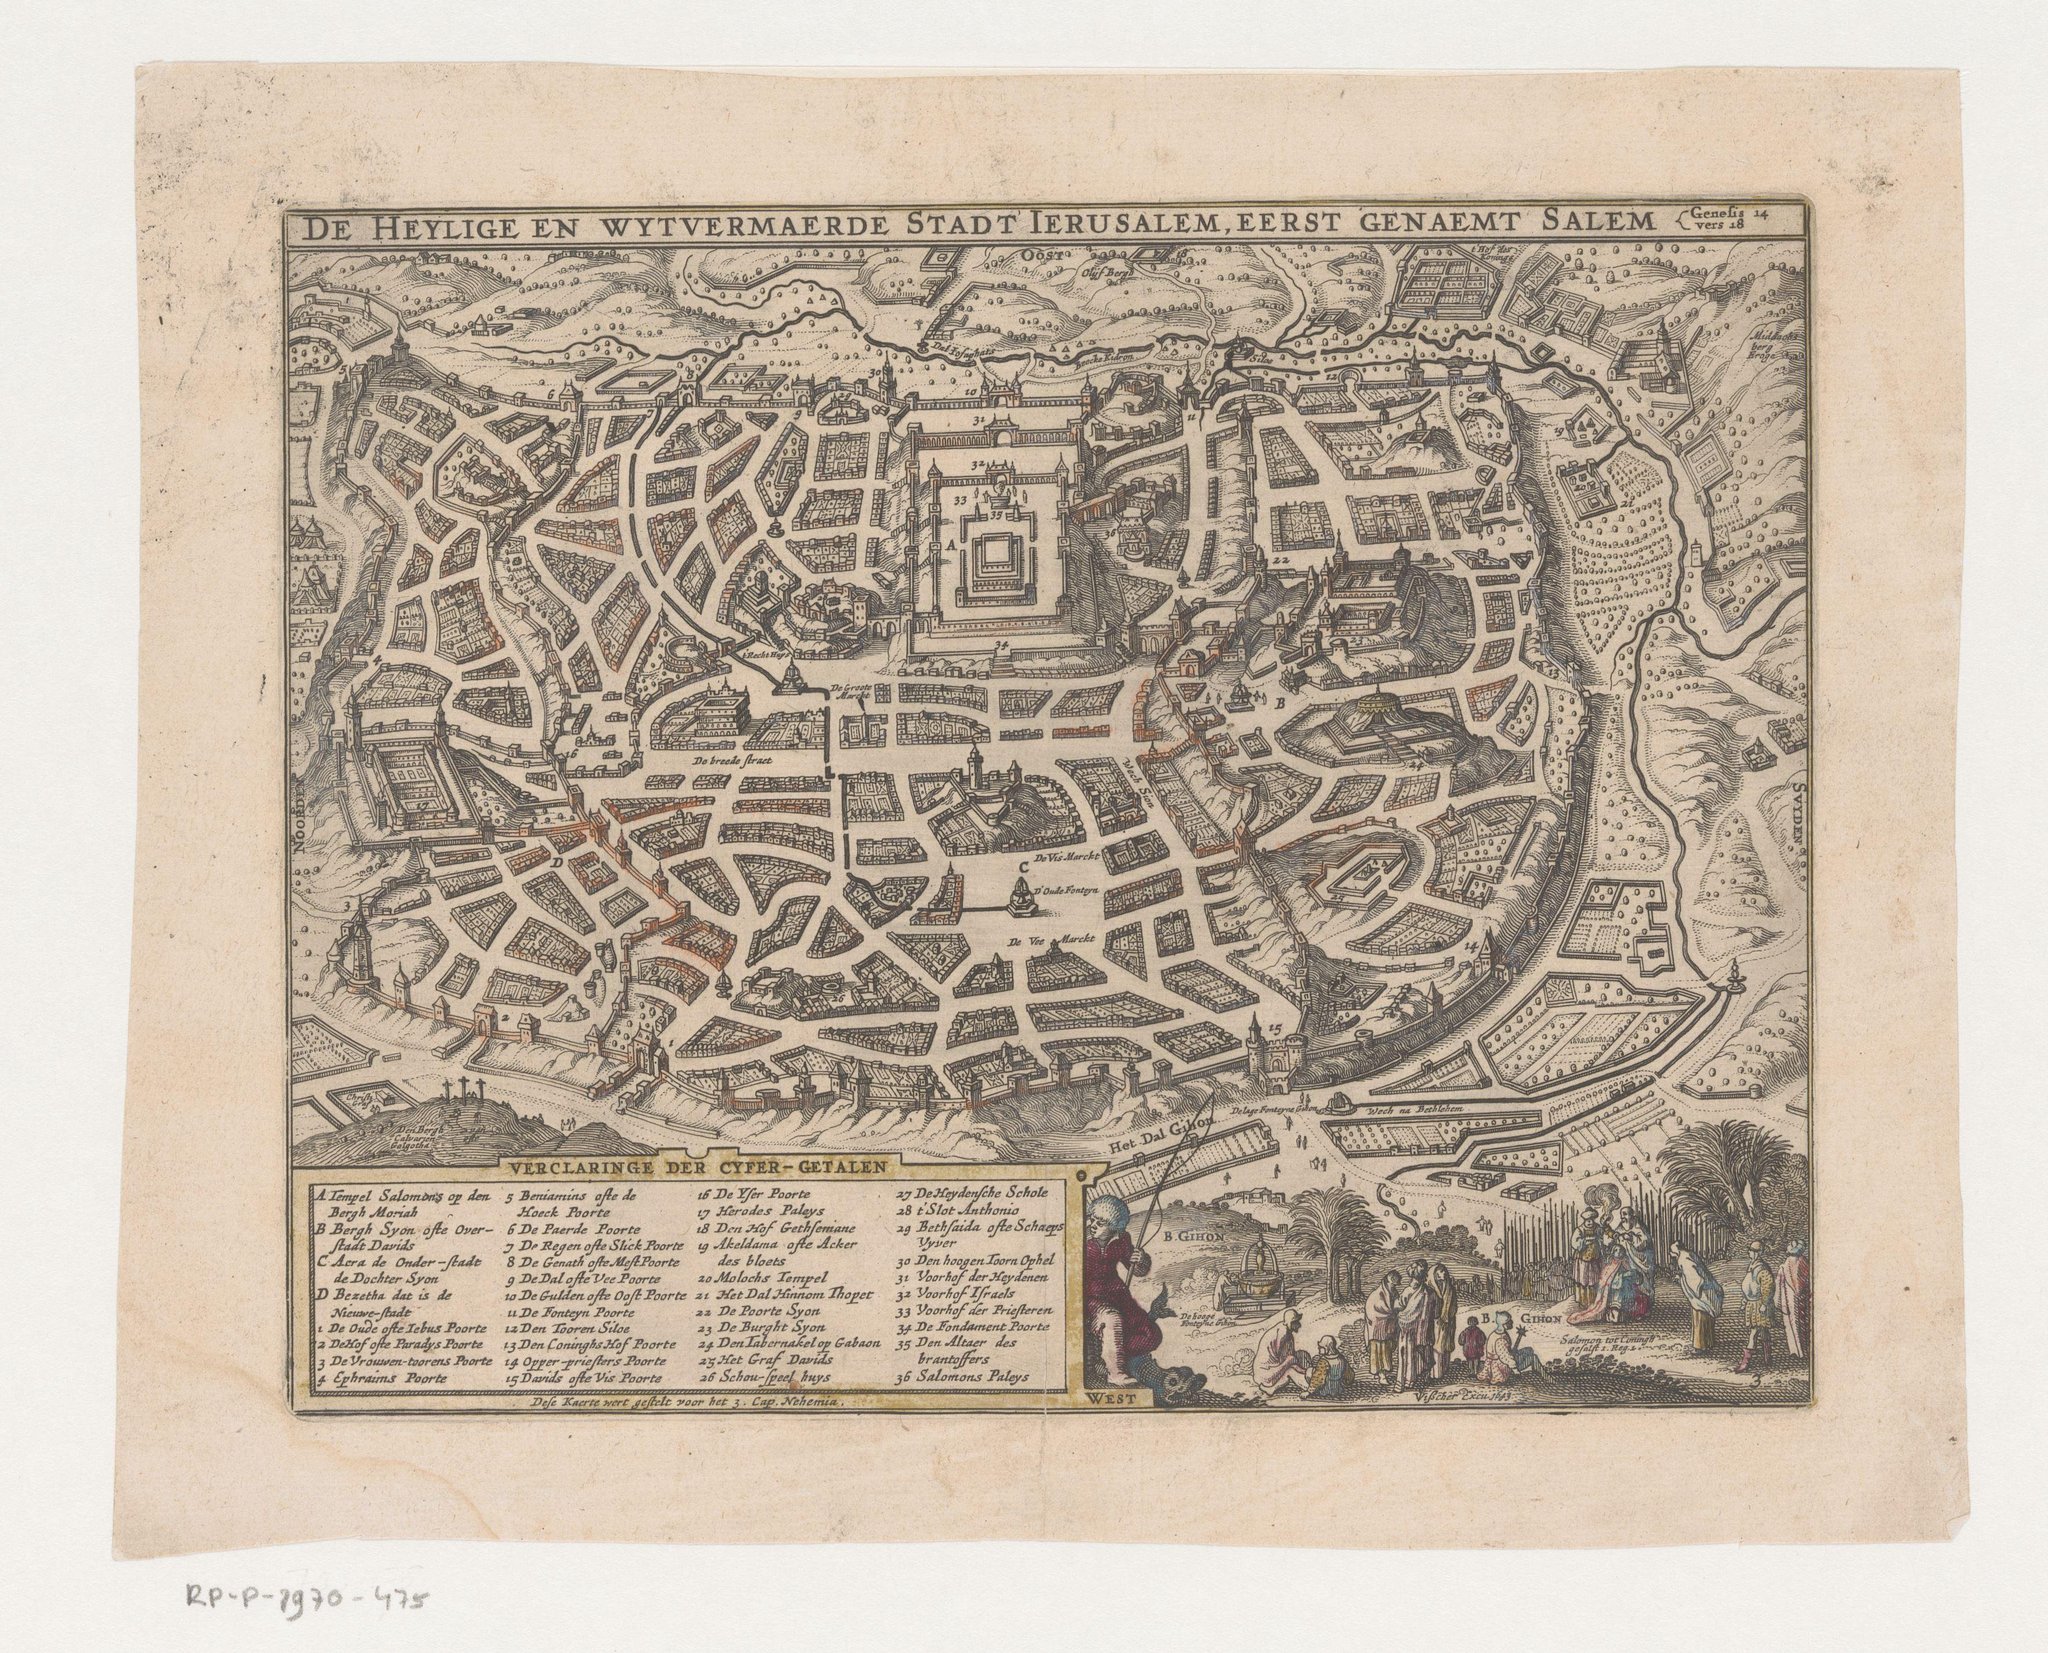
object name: print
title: Vogelvluchtaanzicht van Jeruzalem, 1643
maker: claes jansz. visscher (ii)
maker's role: draughtsman, print maker, publisher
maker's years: 1586-1652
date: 1643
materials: paper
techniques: etching, hand coloring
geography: amsterdam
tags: maps of cities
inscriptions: collector's mark: Lugt 2228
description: Imaginair vogelvluchtaanzicht van de stad Jeruzalem. Linksonder een cartouche met naamsaanduidingen. Rechtsonder is de kroning van Salomon afgebeeld.